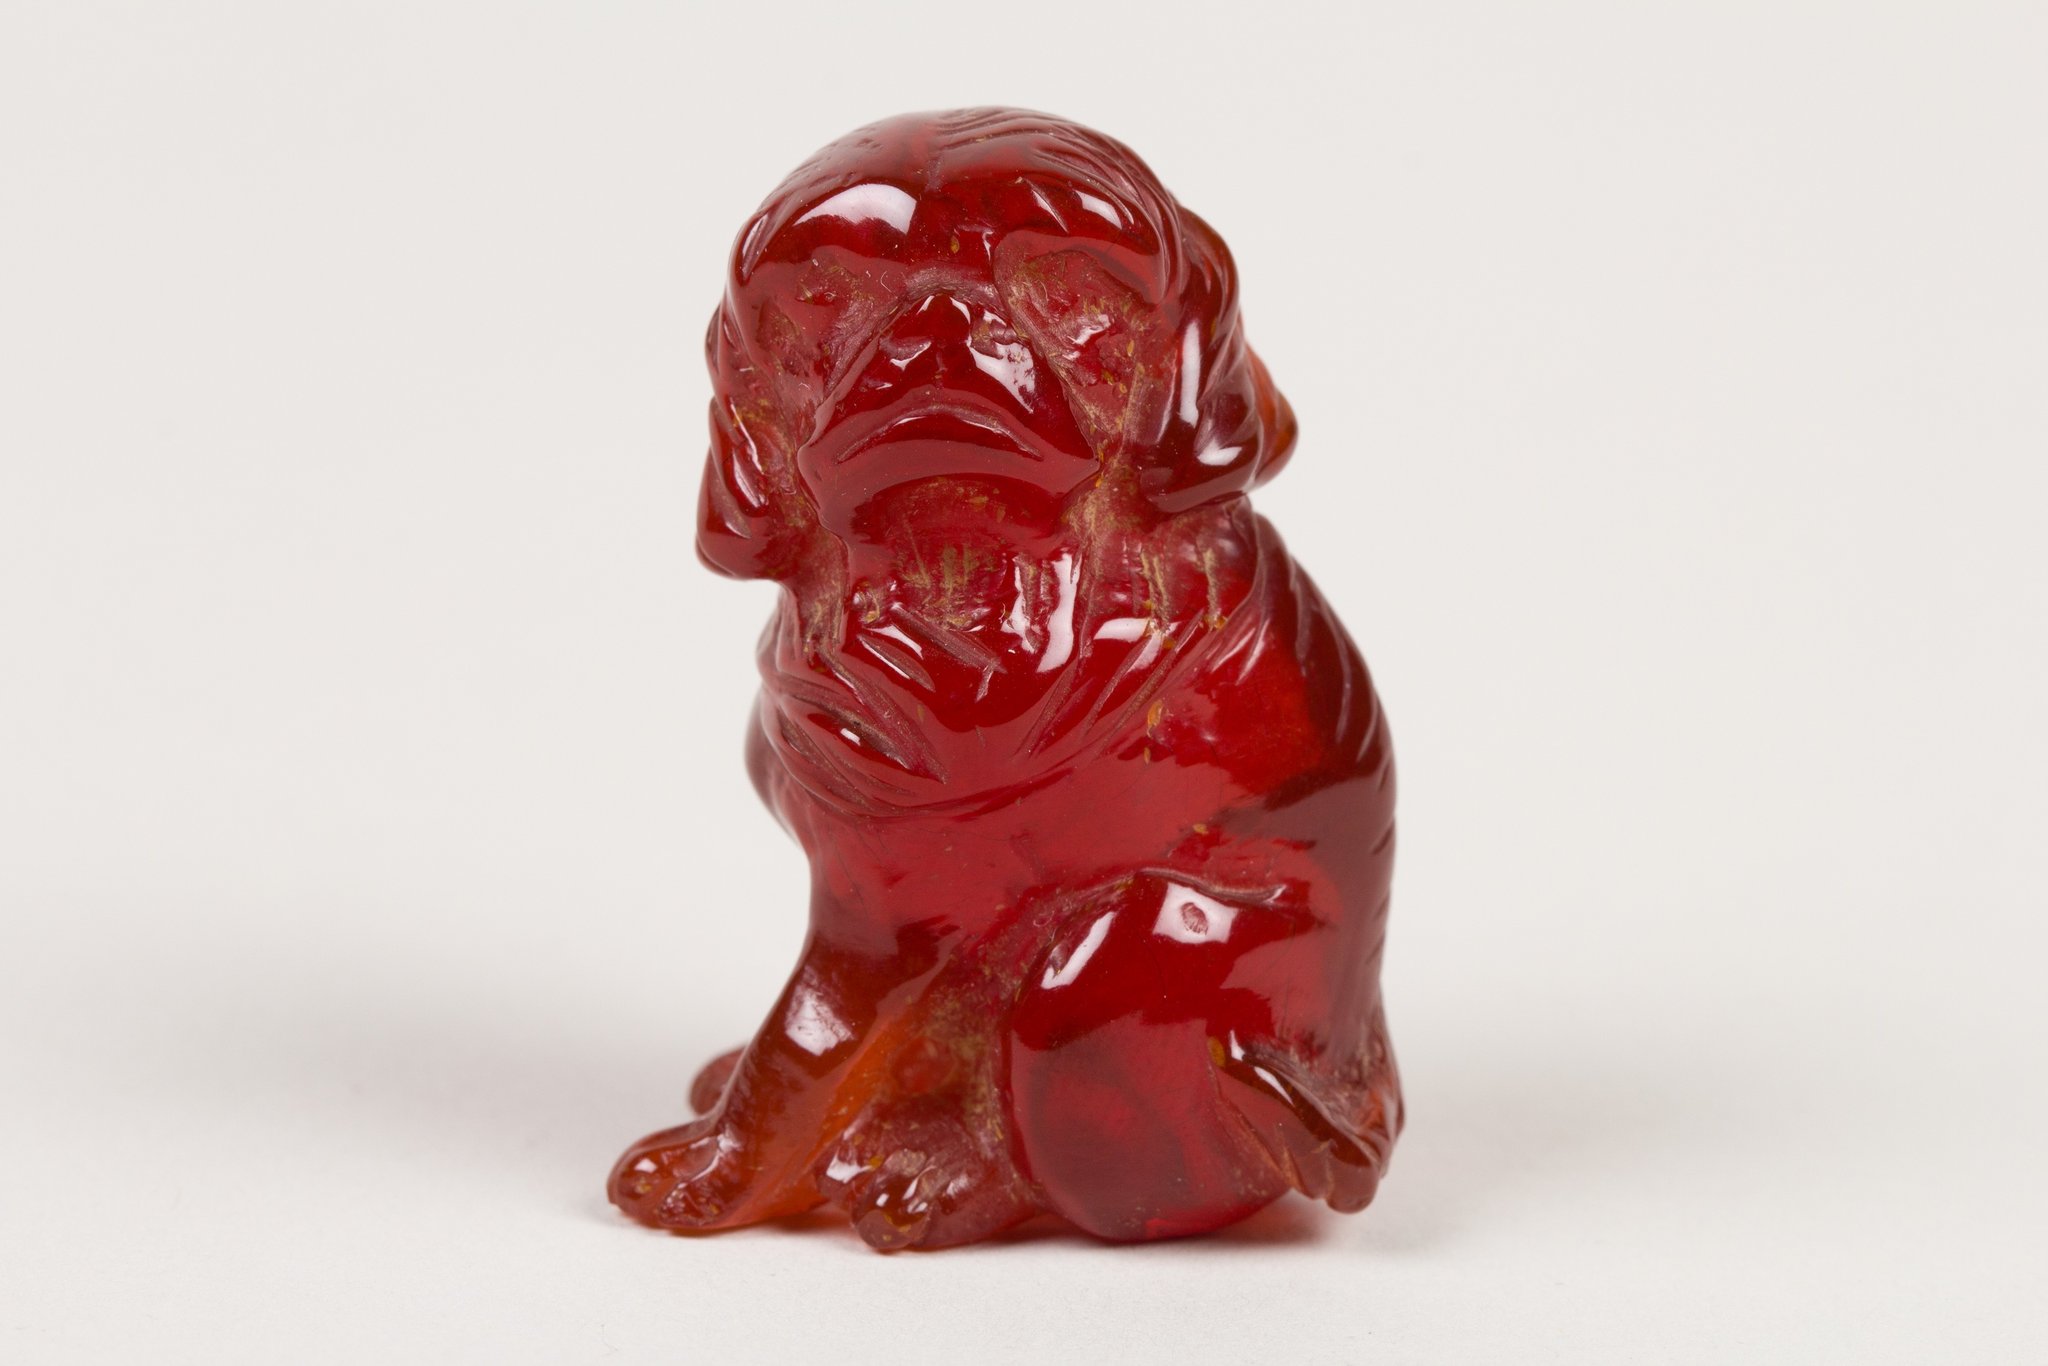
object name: netsuke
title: Netsuke of Seated Dog (one of a pair)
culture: japanese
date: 1867-1933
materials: amber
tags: dogs